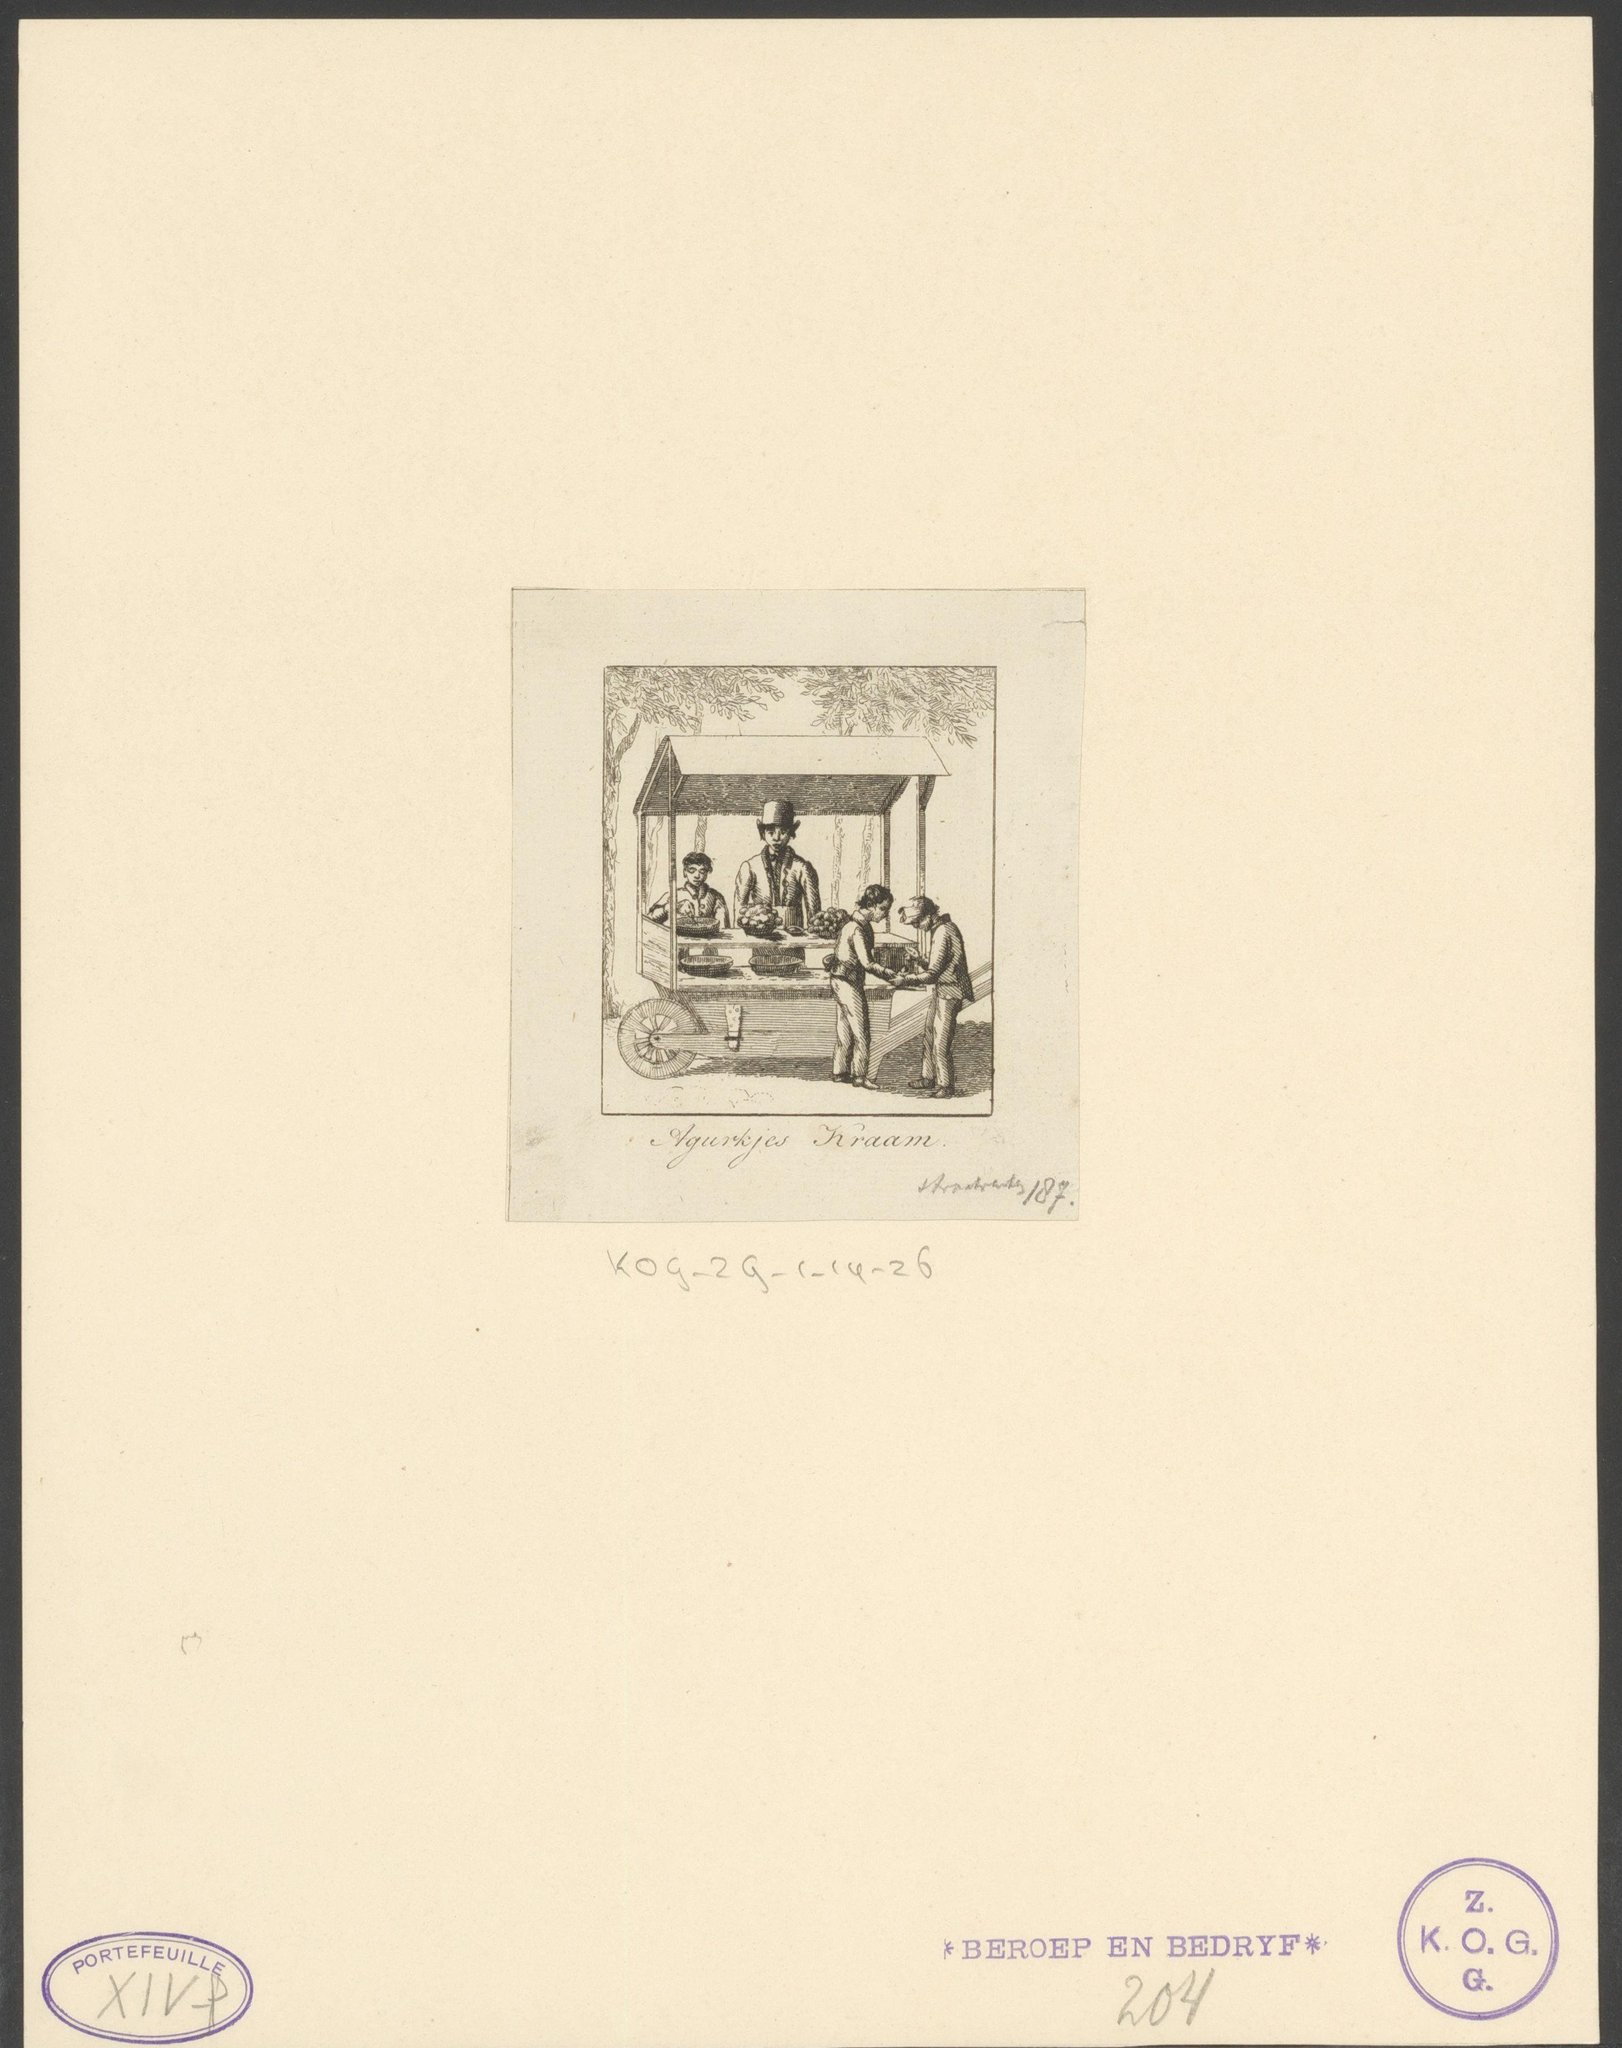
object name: print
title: Agurkjes Kraam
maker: Anonymous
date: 1800-1899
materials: paper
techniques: etching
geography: netherlands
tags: vegetables, street-trader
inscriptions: collector's mark: Lugt 1641, collector's mark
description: Kraam op straat waar augurken worden verkocht. Onderwerpsrubrieken binnen de Atlas Zeden en Gewoonten: Mannelijk beroep en bedrijf: Marskramers, straatventers, straatslijpers, bedelaars, straatvertooningen enz.